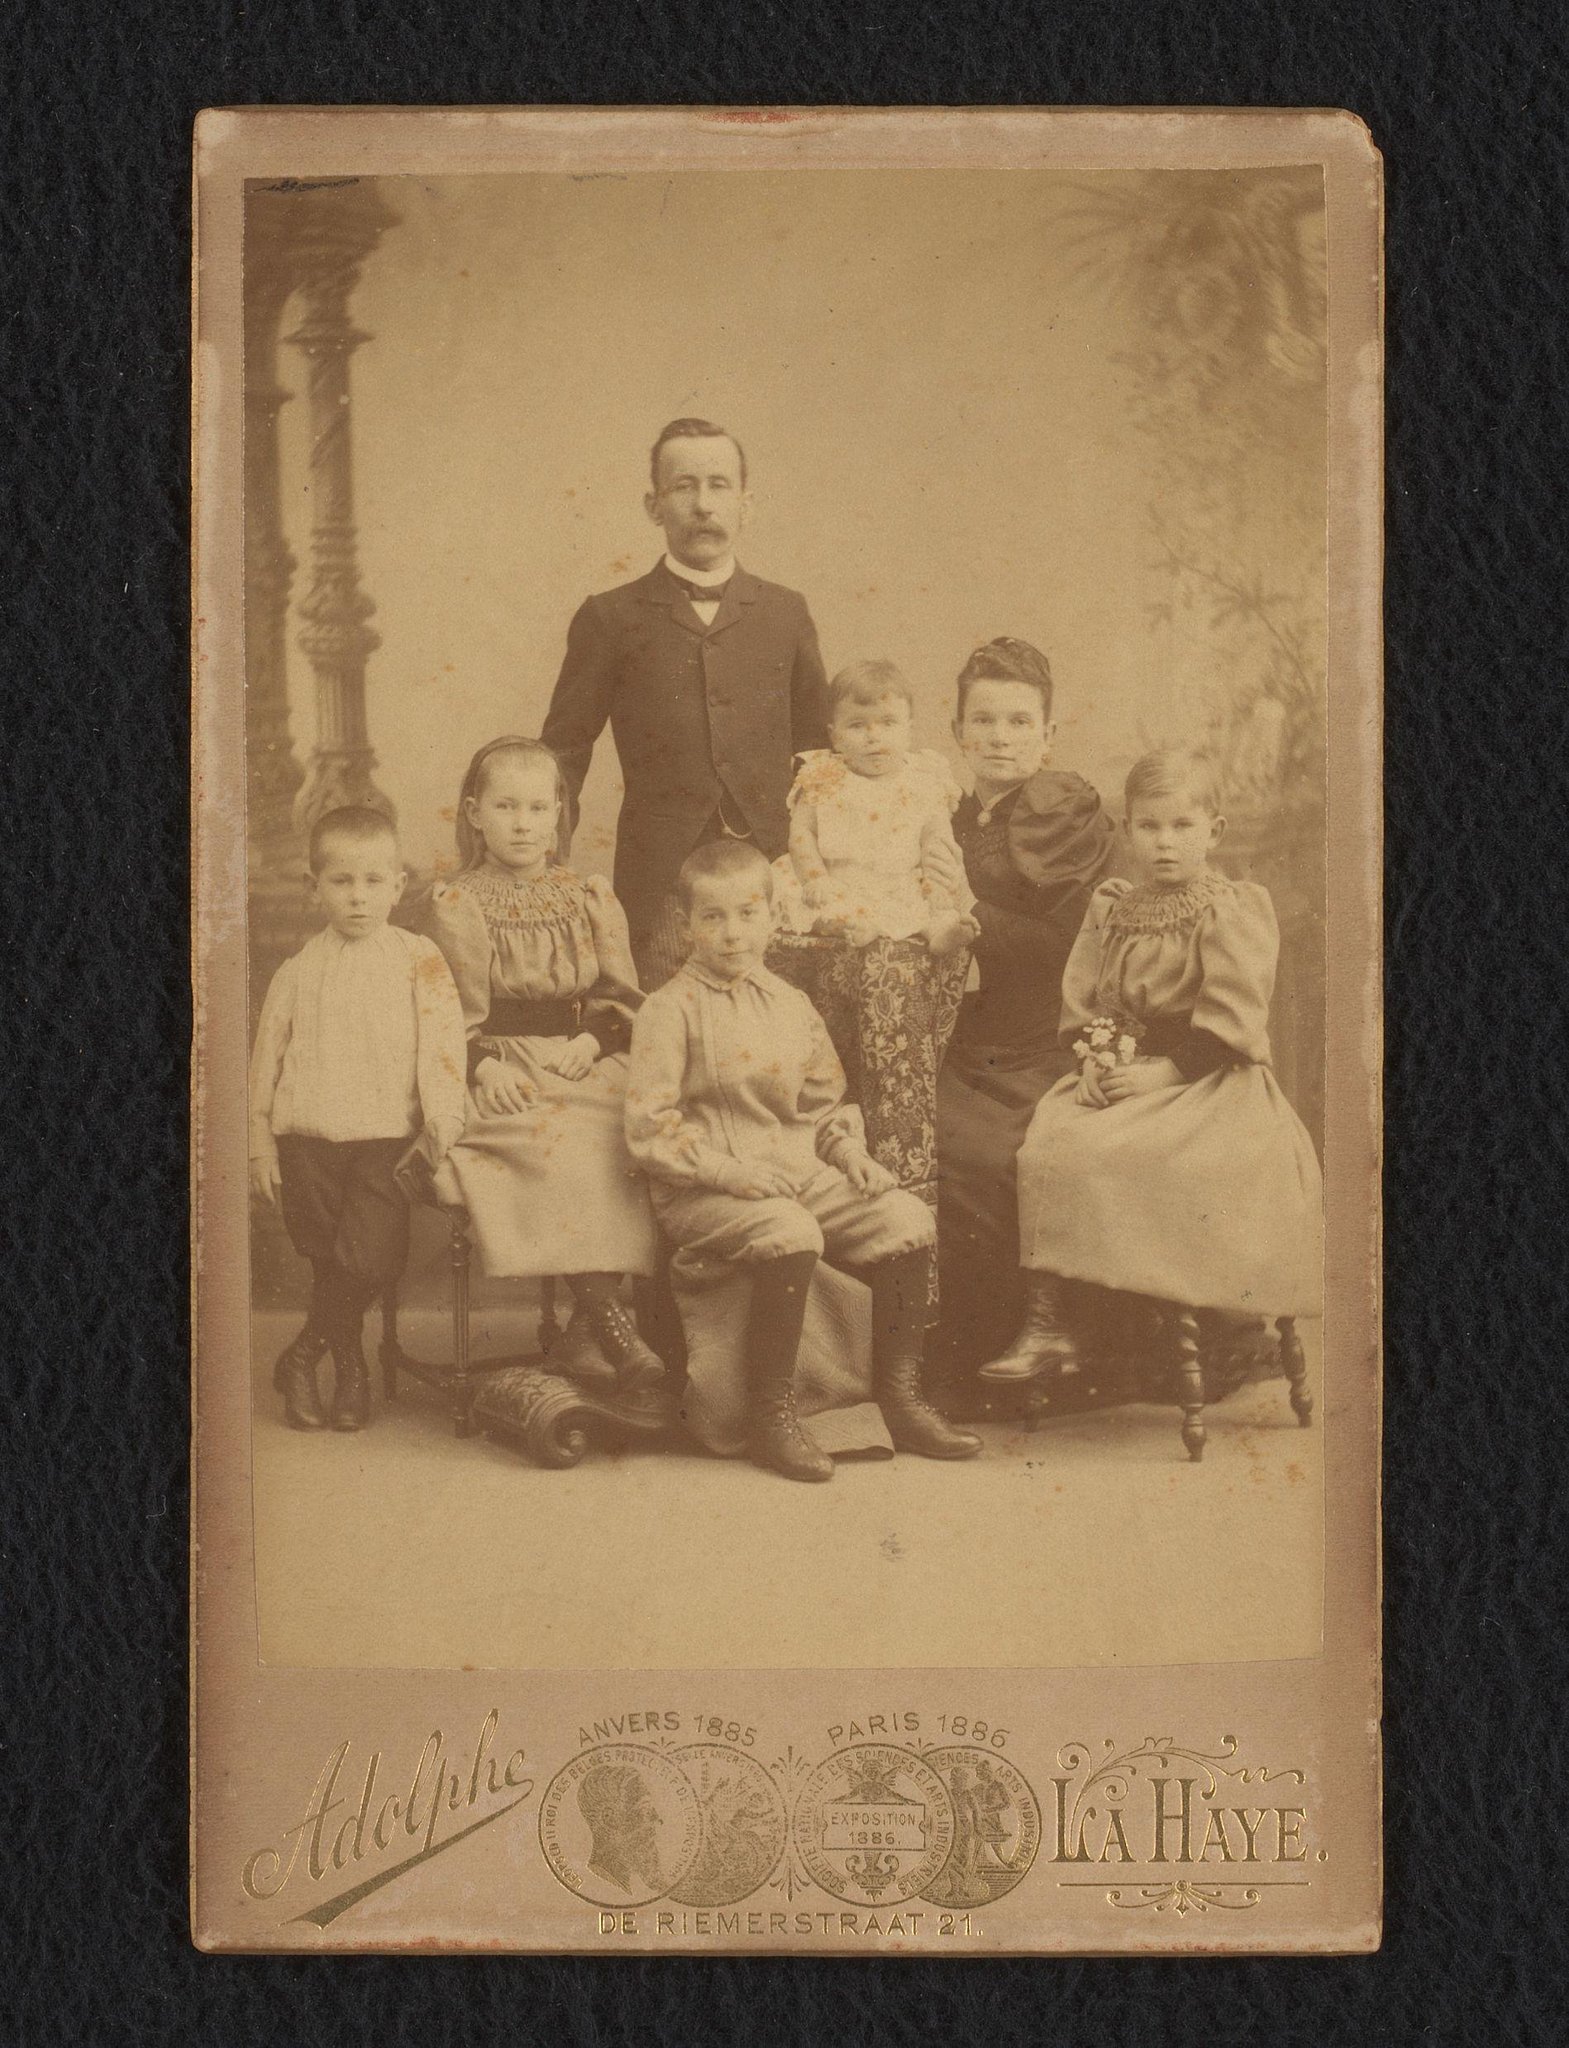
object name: cabinet photograph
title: Groepsportret van het gezin van August Kessler (iedereen behalve Go)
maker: adolphe zimmermans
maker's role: fotograaf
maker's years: 1858-1922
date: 1896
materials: cardboard, paper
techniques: albumen print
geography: the hague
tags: engineer, jean baptiste august kessler (1888-1972), johan herman kessler (jan), batavia, geldolph adriaan kessler (dolph), margaretha jacoba johanna kessler-de lange (margo), jean baptiste august kessler (1853-1900), the hague, hermann johannes kessler (boelie), historical persons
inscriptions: address: ‘La Haye./ DE RIEMERSTRAAT 21.’